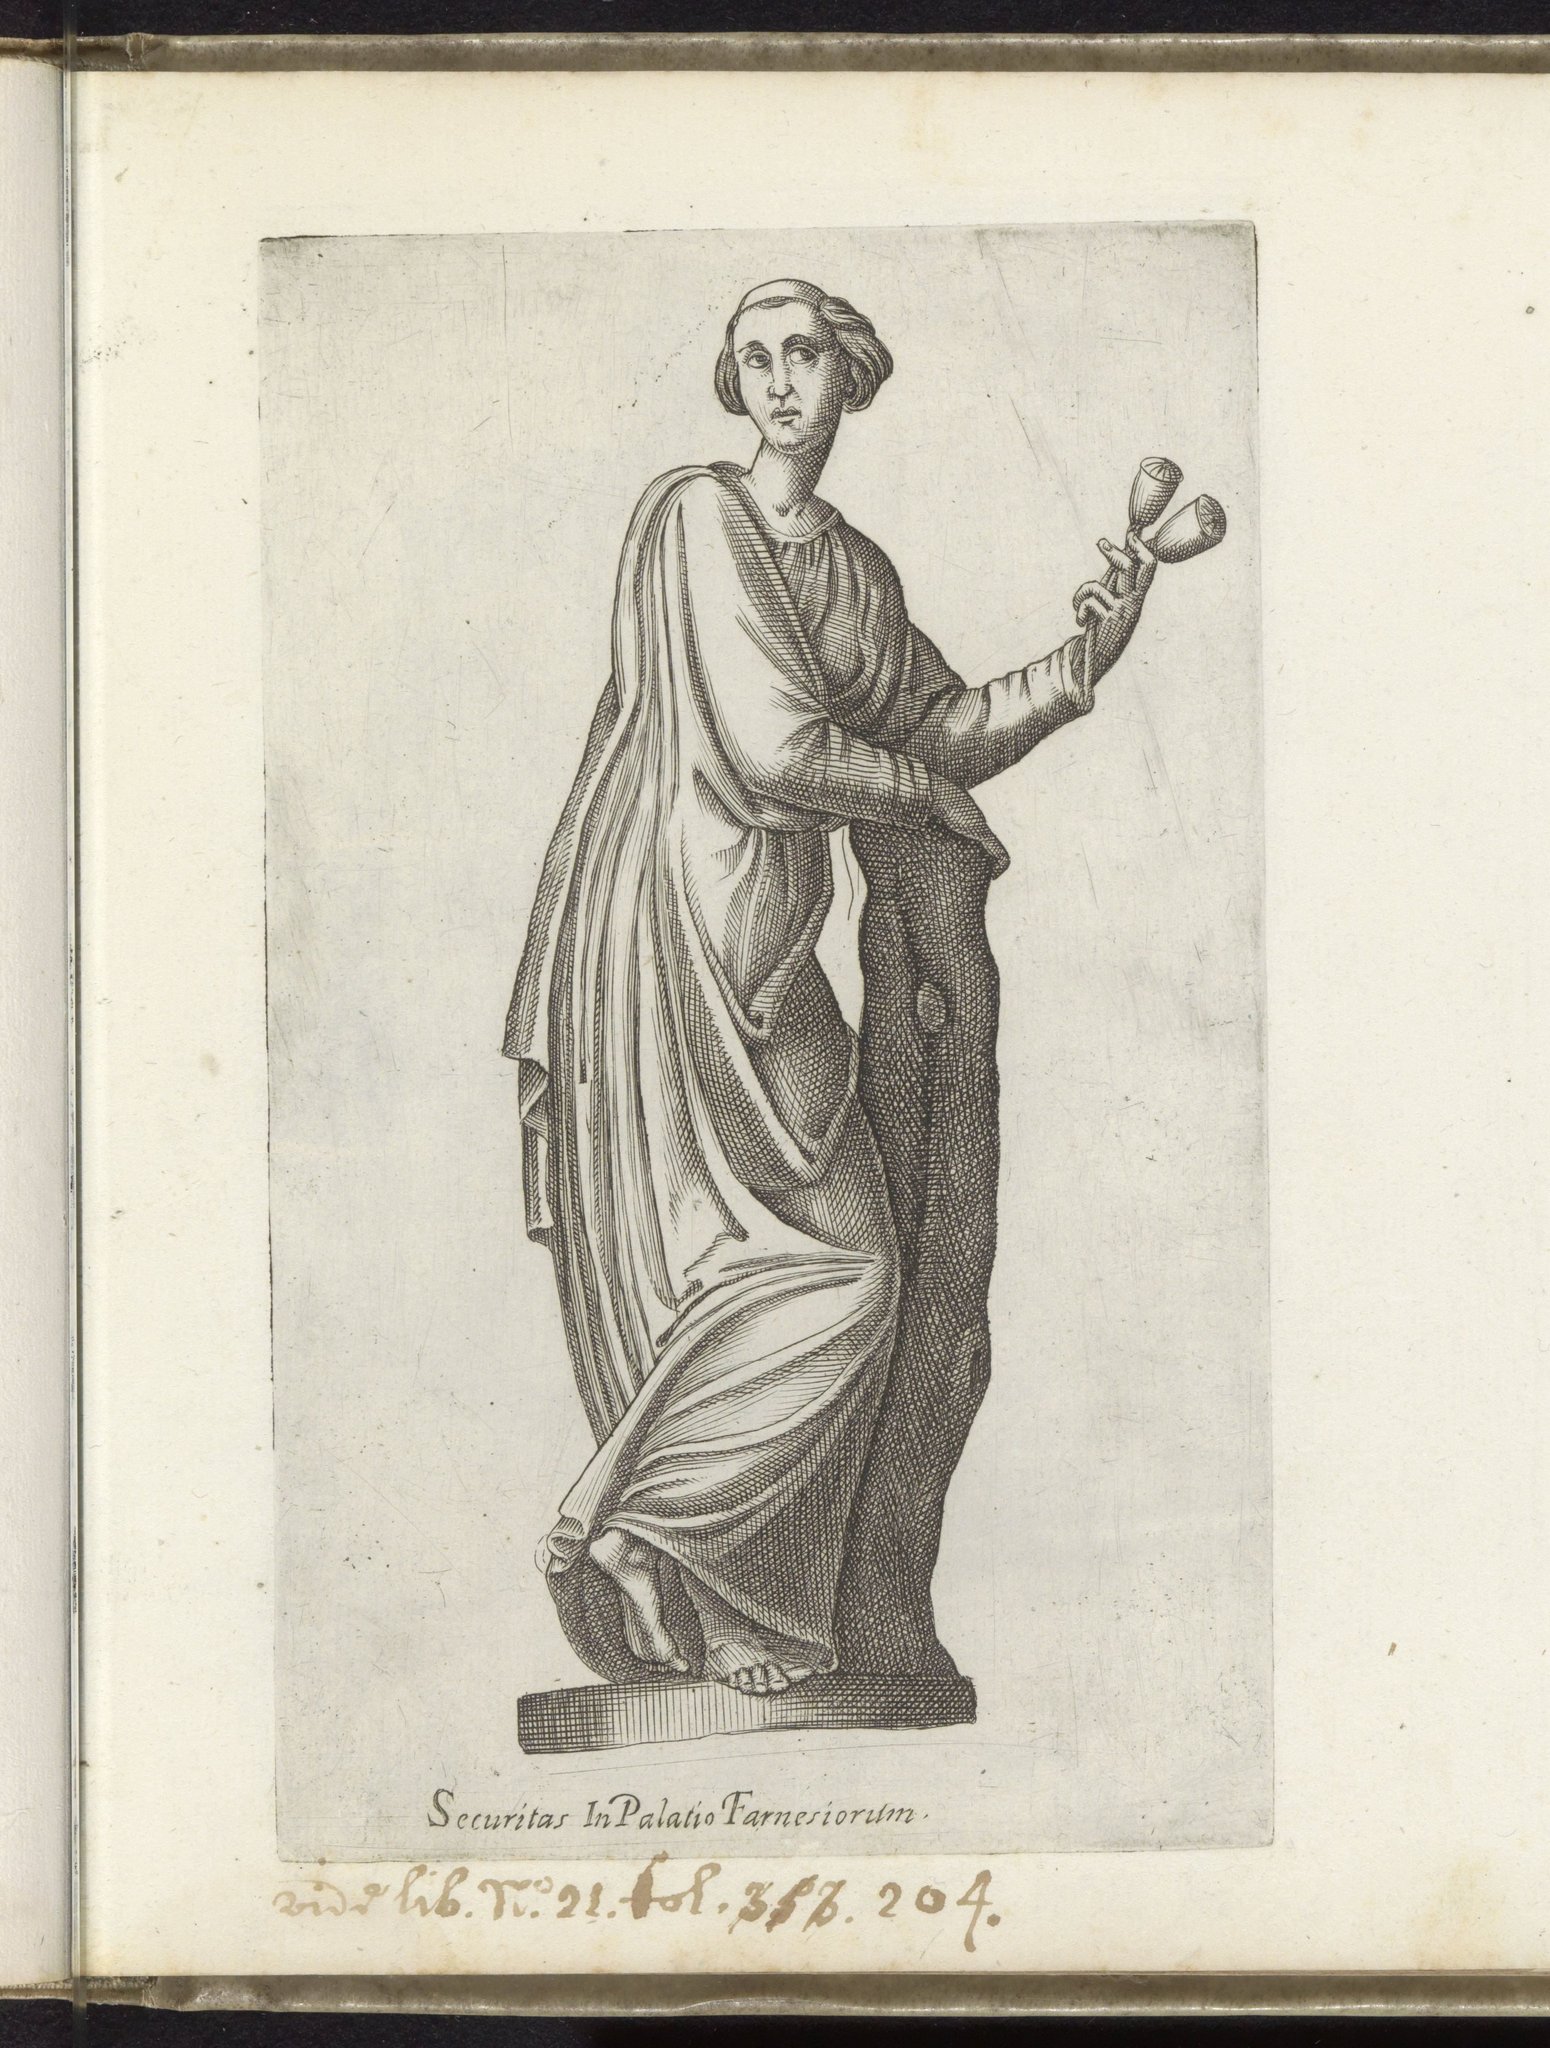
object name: print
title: Sculptuur van Securitas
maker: Anonymous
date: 1600-1699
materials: paper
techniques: engraving, etching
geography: italy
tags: securitas as roman personification, piece of sculpture, reproduction of a piece of sculpture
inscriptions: number: ‘69’, inscription: ‘Ende lib. No. 21. fol. 353[doorgestreept]. 204.’, inscription: ‘Ende lib. No. 4 [...] fol. 122. lib. No. 5. fol. 102./ Ende lib. No. 21. fol. 402.’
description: Deze prent maakt deel uit van een reeks van ten minste 50 prenten van sculpturen uit de oudheid.